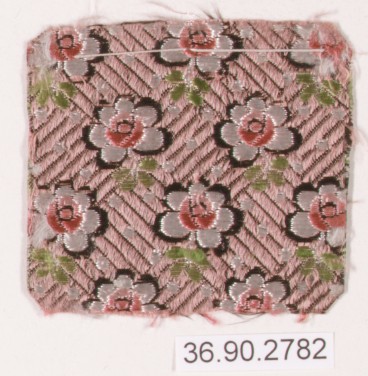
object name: piece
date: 1801-1900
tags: flowers,leaves